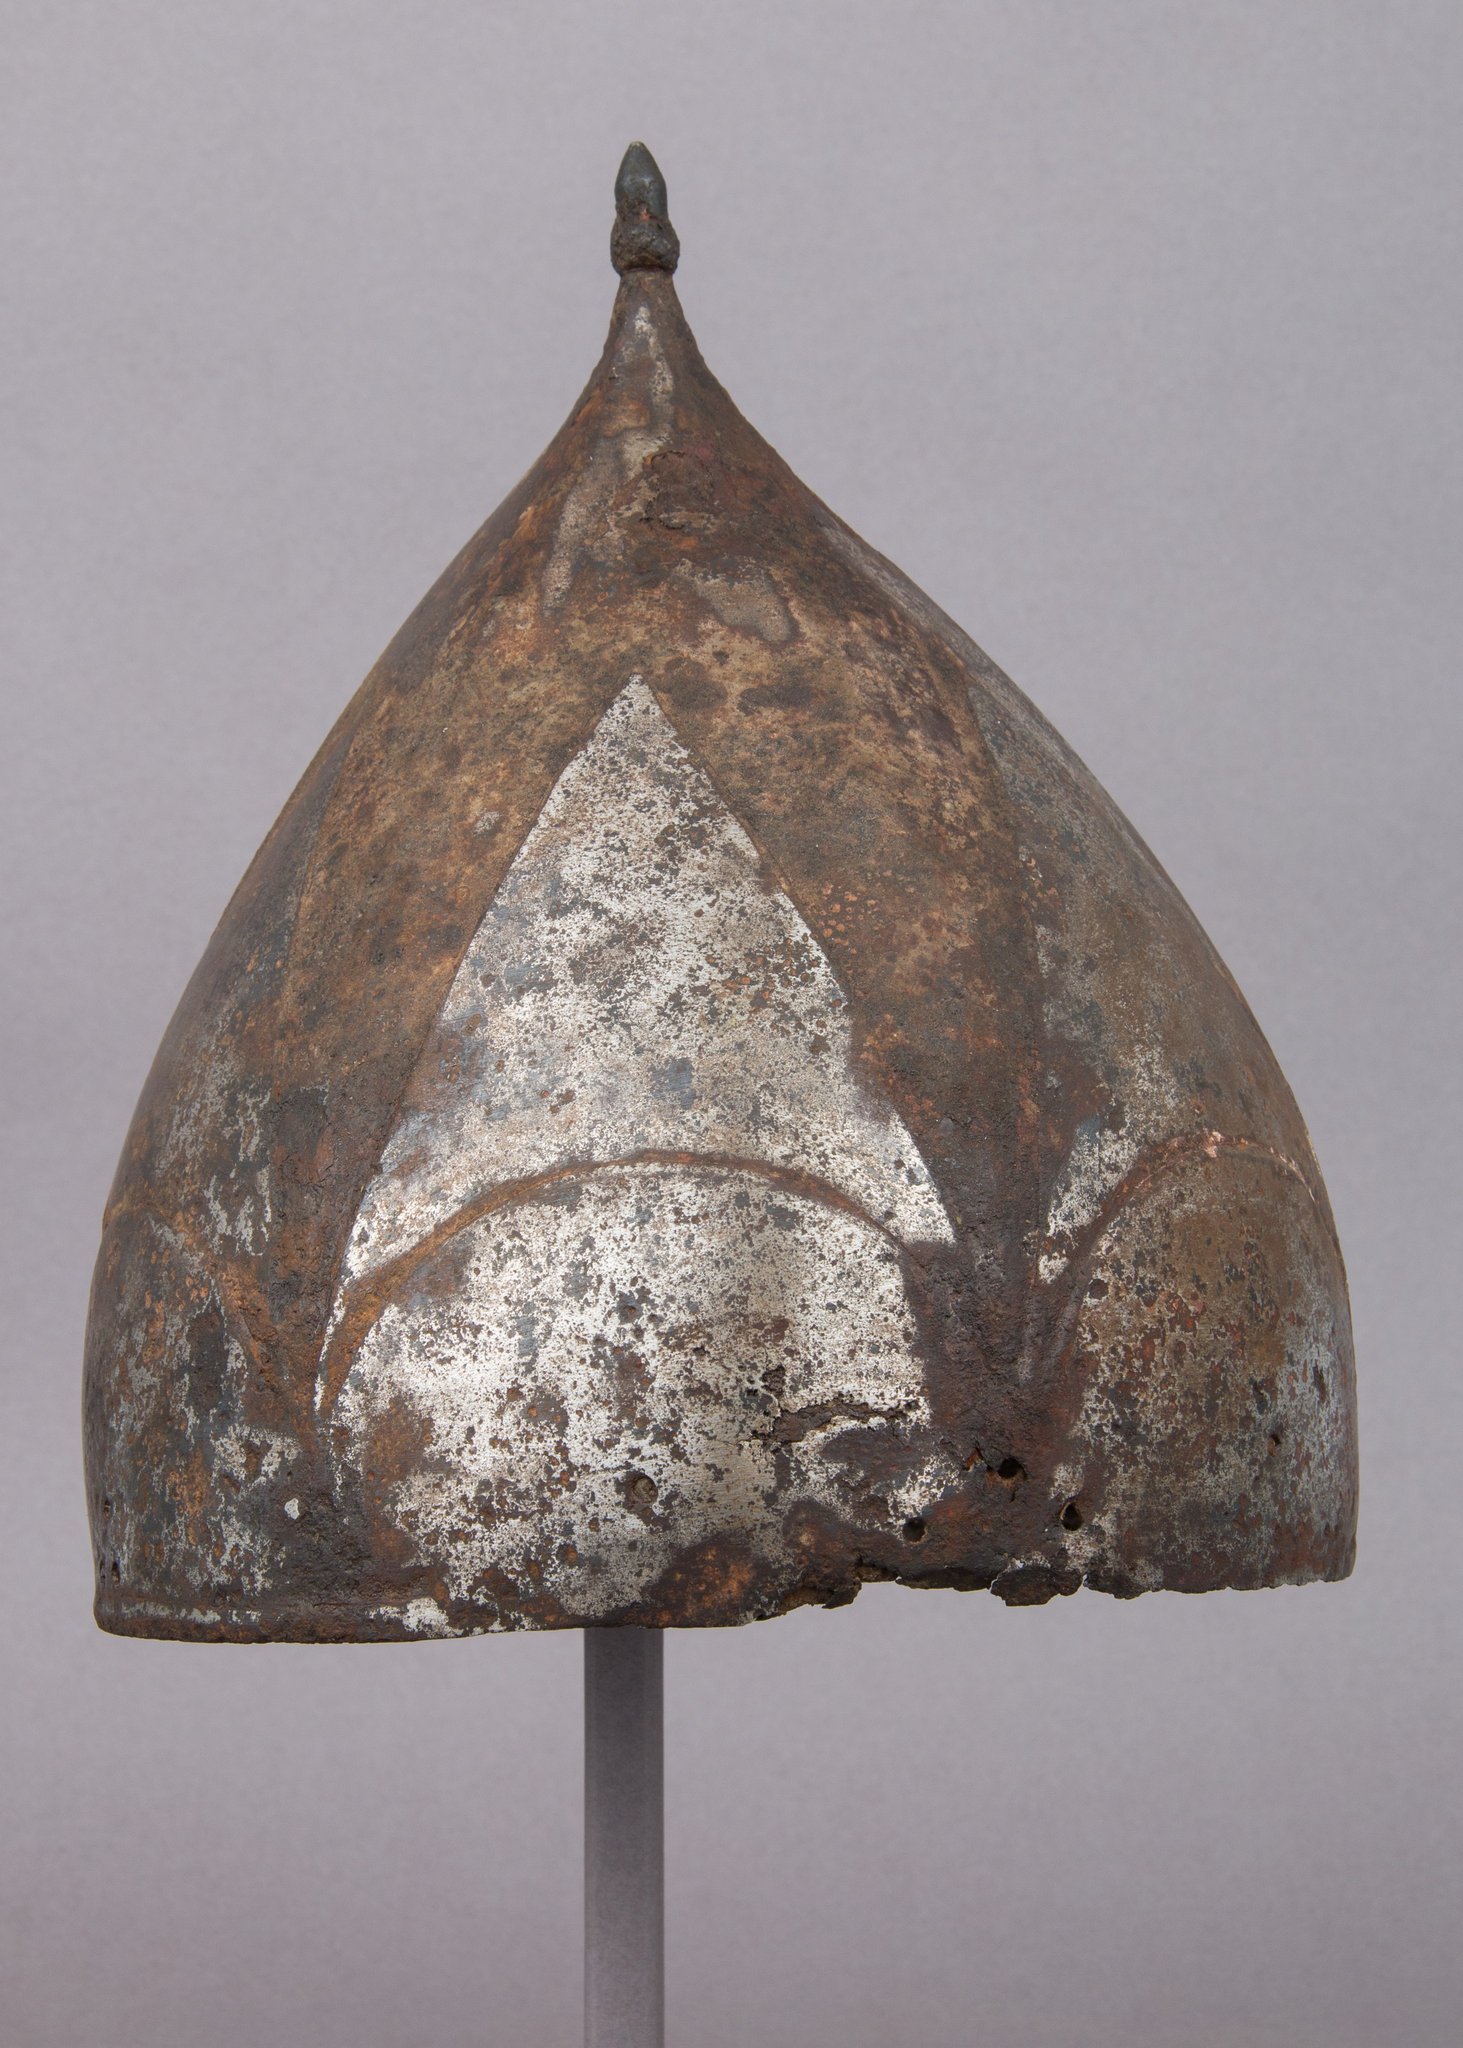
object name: helmet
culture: turkish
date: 1501-1700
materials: iron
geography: ottoman empire